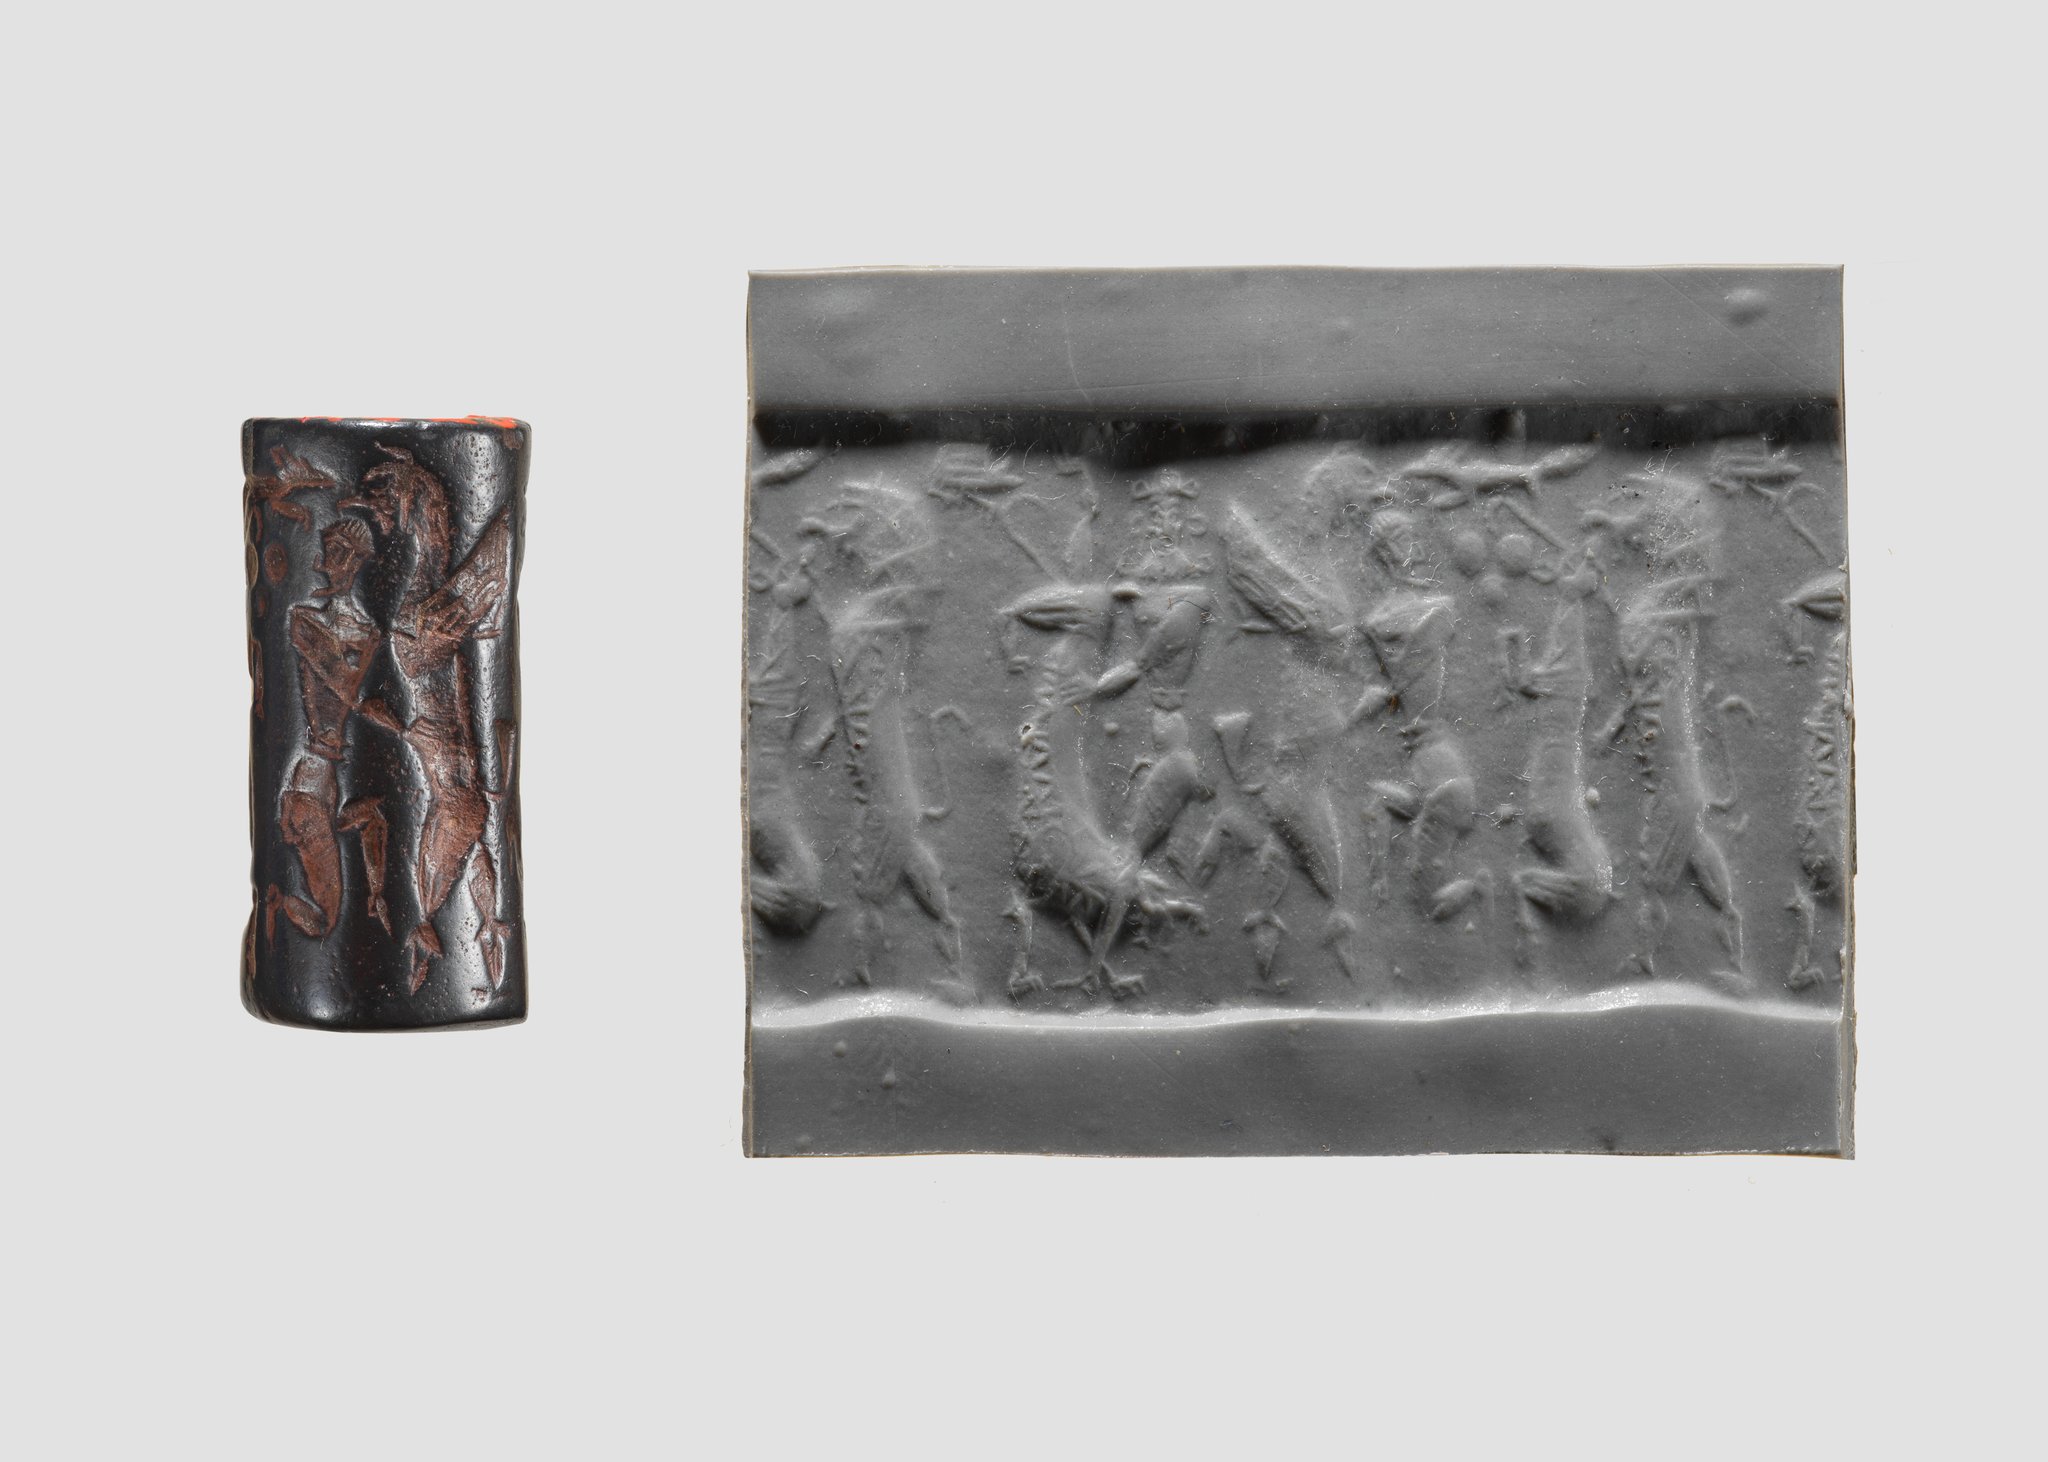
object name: cylinder seal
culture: babylonian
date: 2000-1668 BCE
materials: mineral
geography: mesopotamia